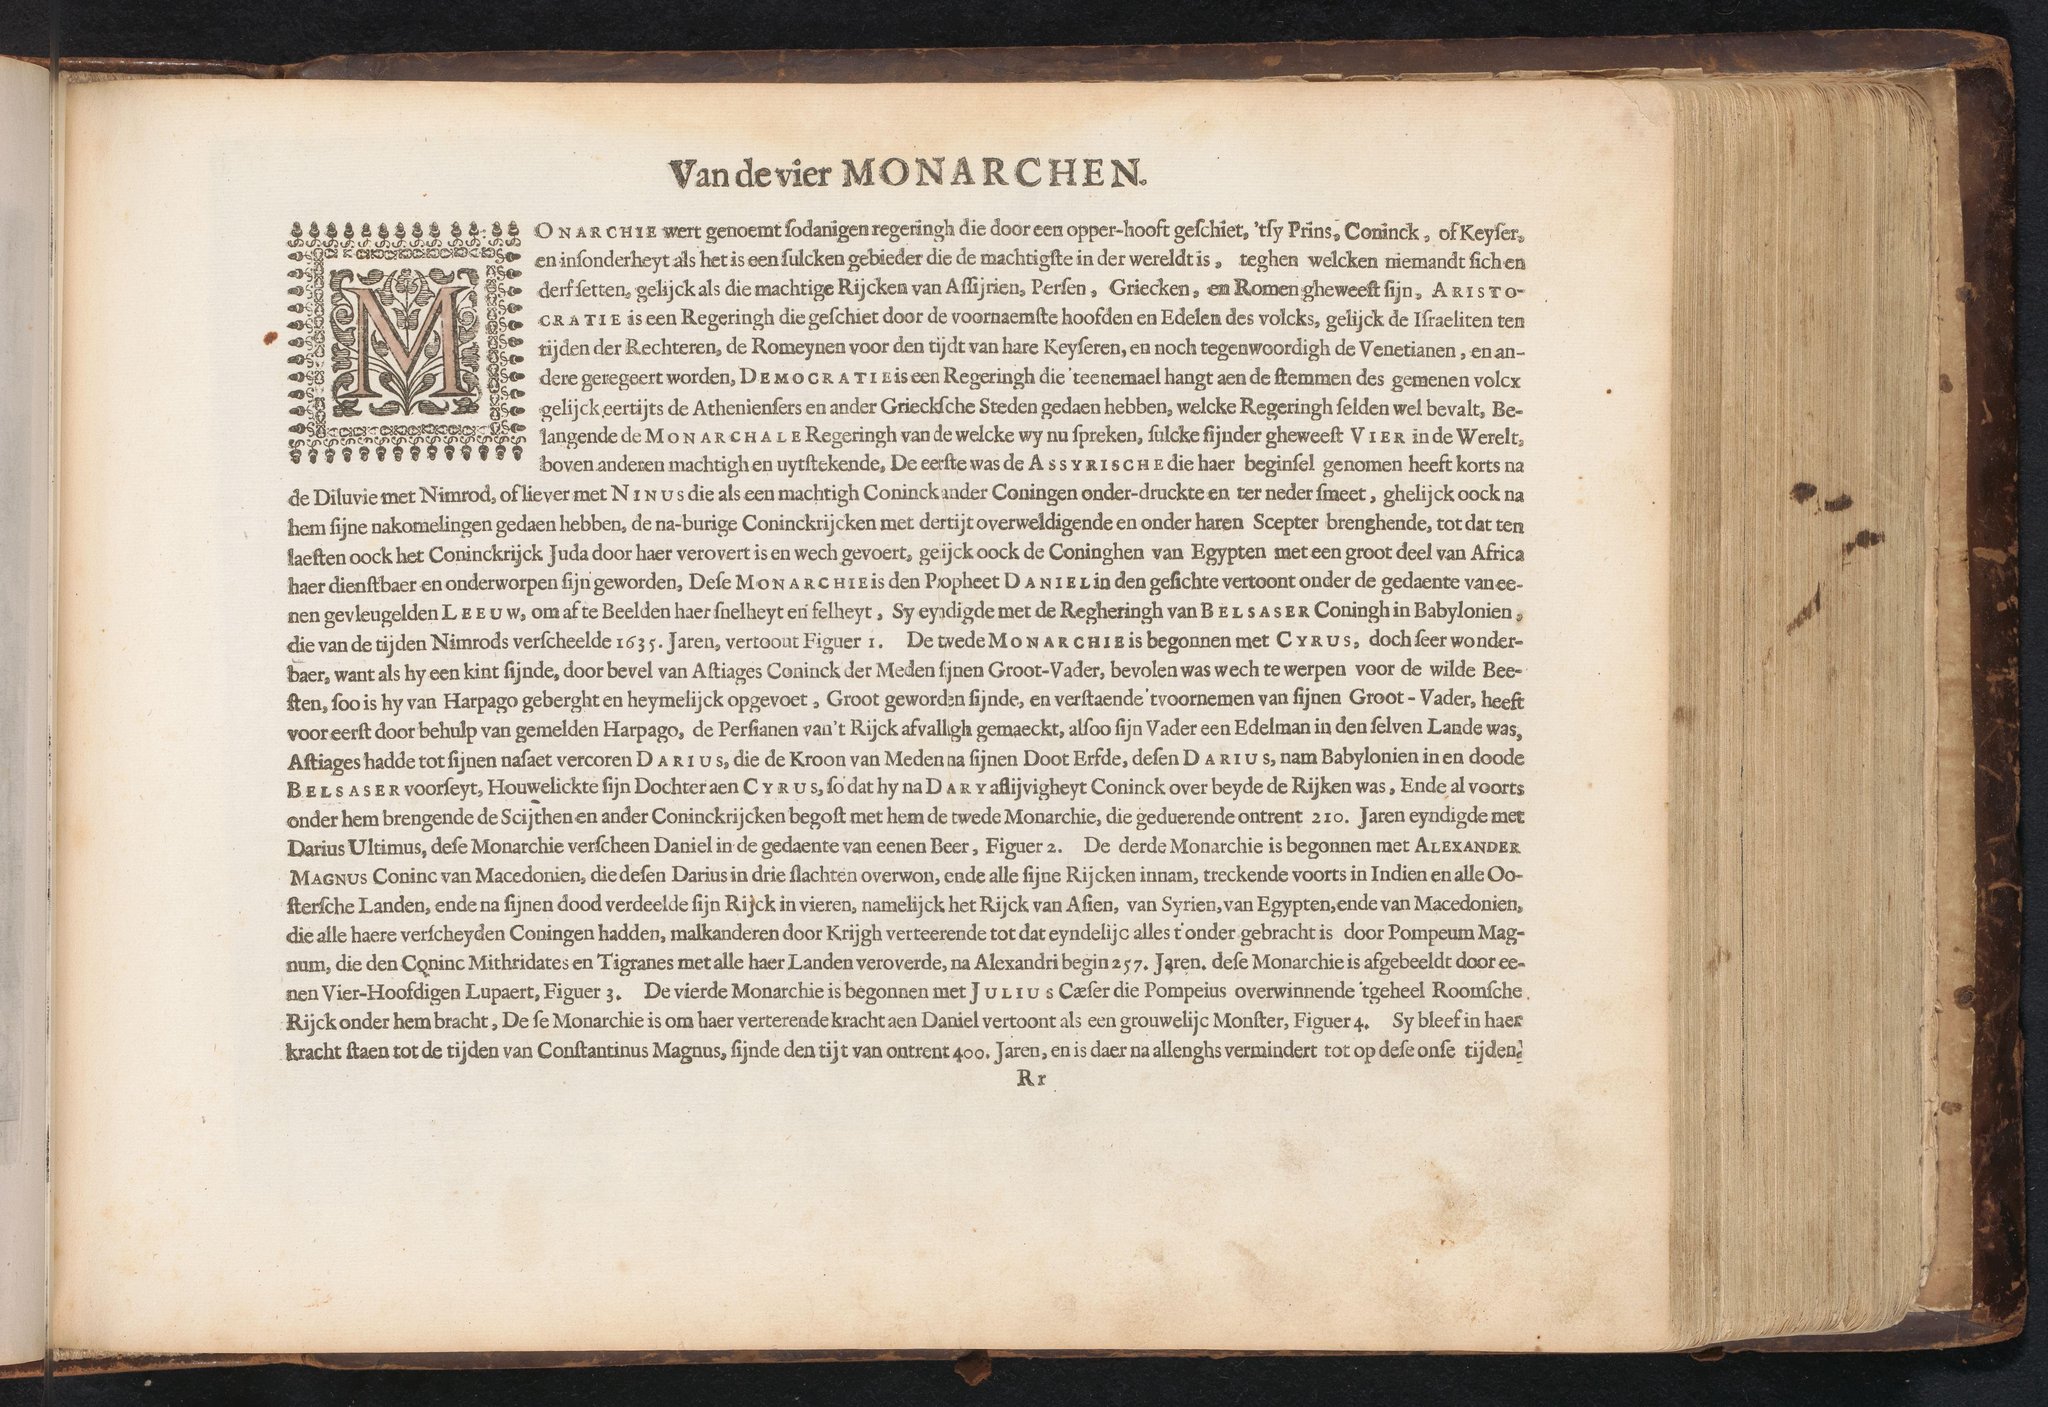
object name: text sheet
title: Van de vier Monarchen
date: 1646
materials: paper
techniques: hand coloring, letterpress printing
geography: alkmaar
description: Tekstblad bij een serie prenten over de opkomst van vier wereldrijken en vier heersers uit het visioen van Daniël. Linksboven initiaal M. Dit blad maakt deel uit van een album.